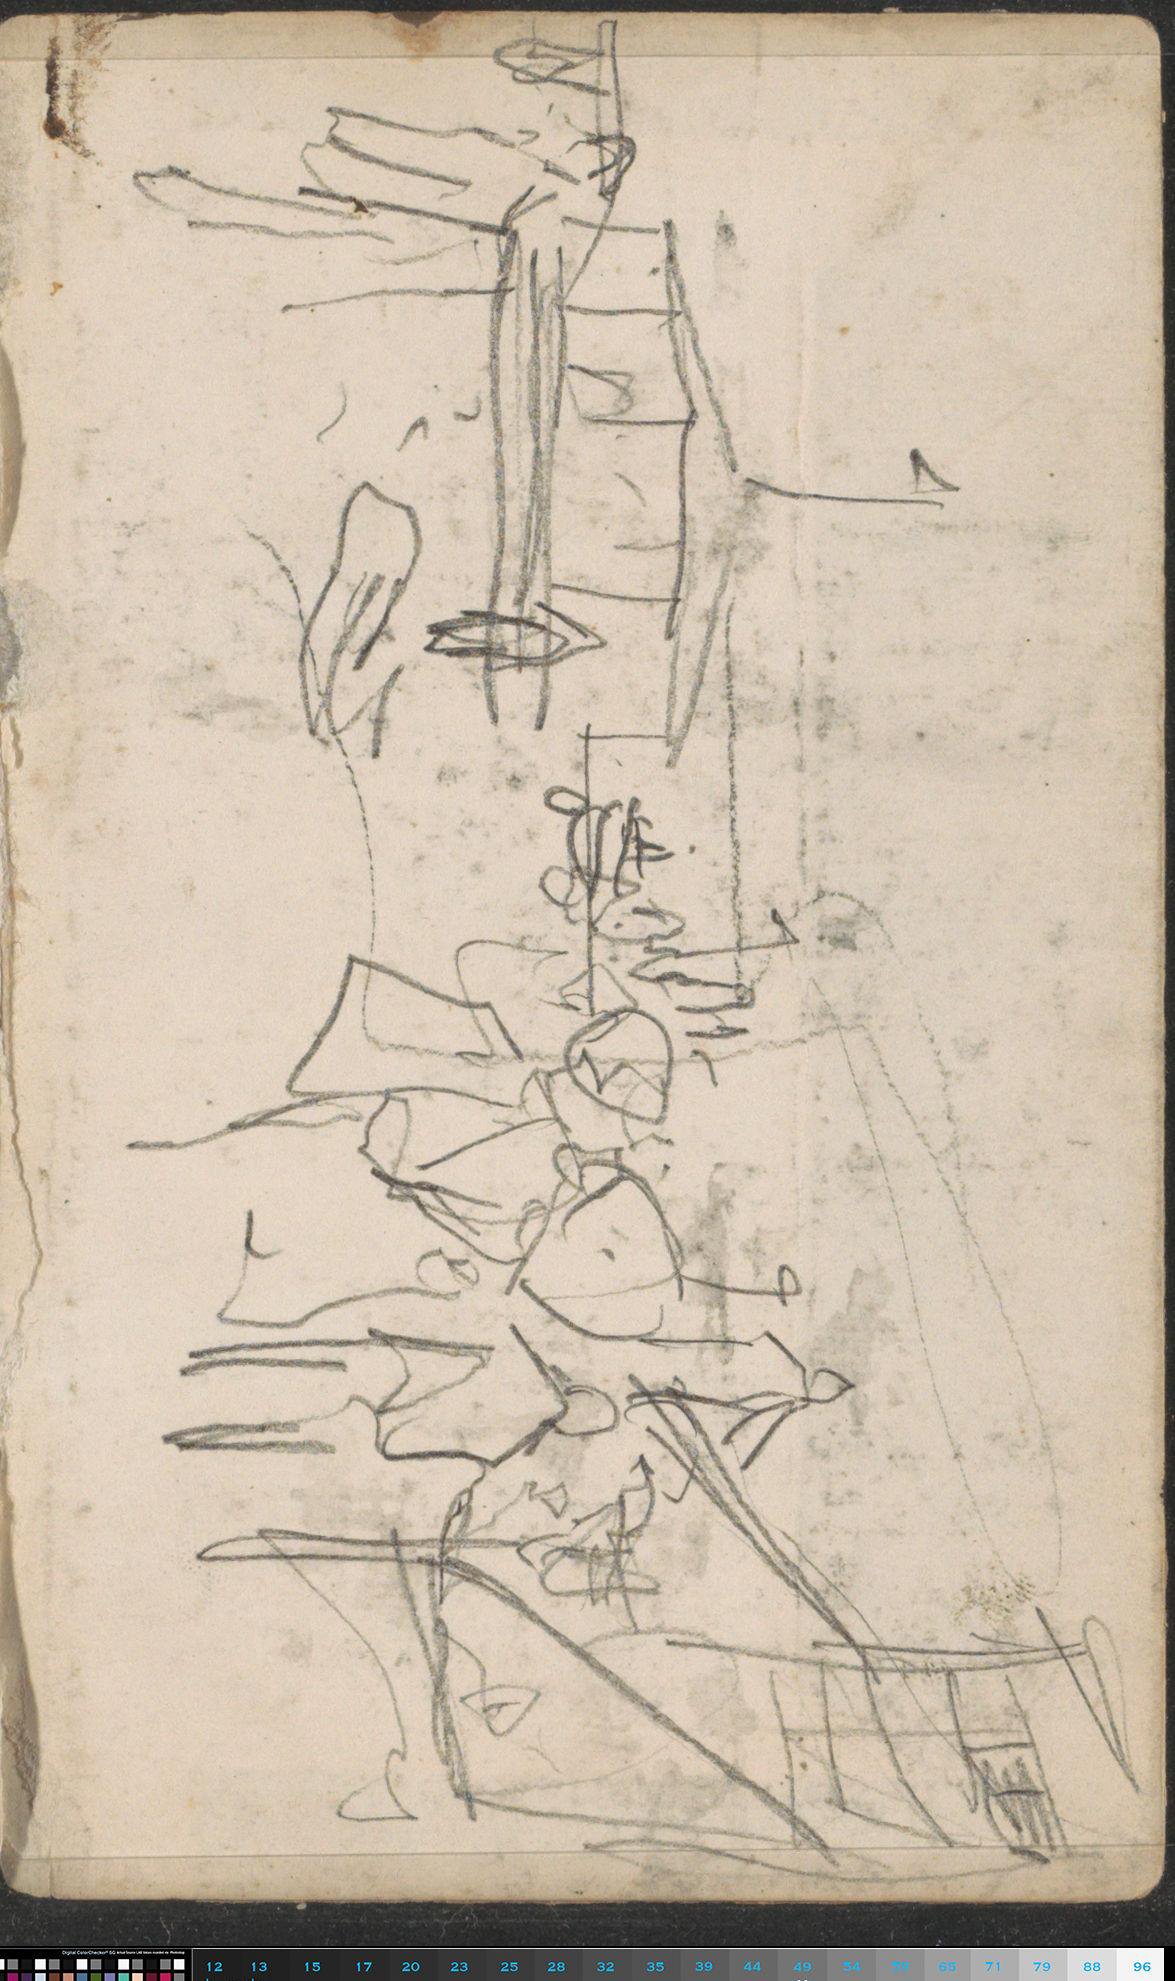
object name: sketchbook leaf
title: Figuren bij een circustent met vlag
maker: marius bauer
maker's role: draughtsman, print maker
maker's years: 1867-1932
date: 1881-1885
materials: pencil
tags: anatomy (non-medical), circus tent (outside)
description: Mogelijk bevinden de figuren zich aan het strand. Achterste schutblad uit een schetsboek met 26 bladen.